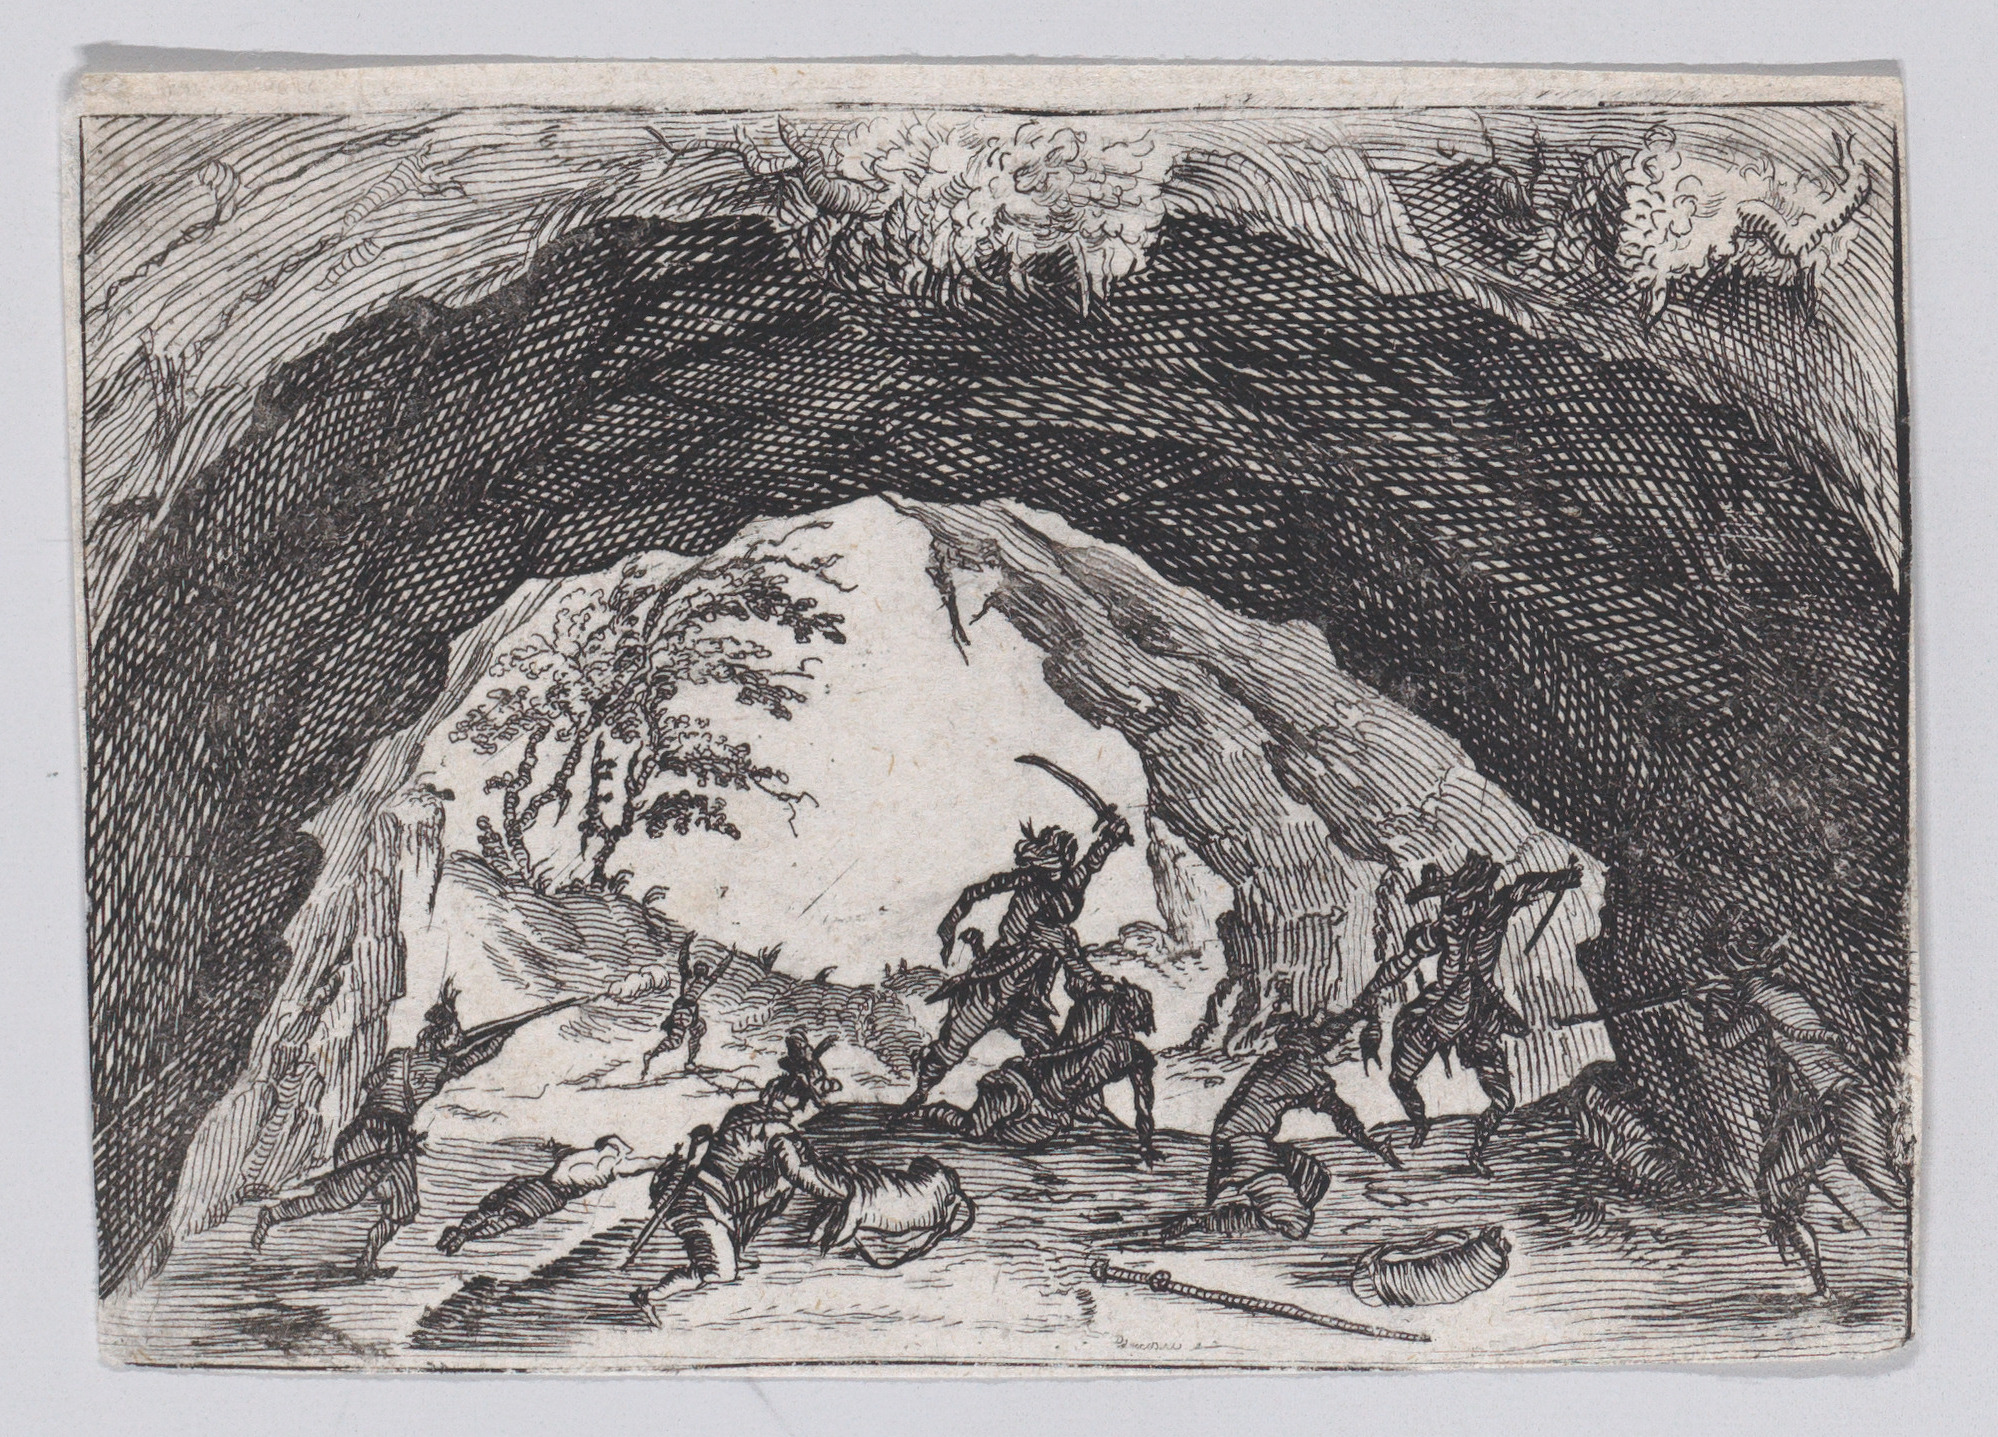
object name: print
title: Reverse Copy of La Caverne de Brigands (The Cave of Thieves), from "Les Caprices"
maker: Anonymous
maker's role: artist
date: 1601-1700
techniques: etching